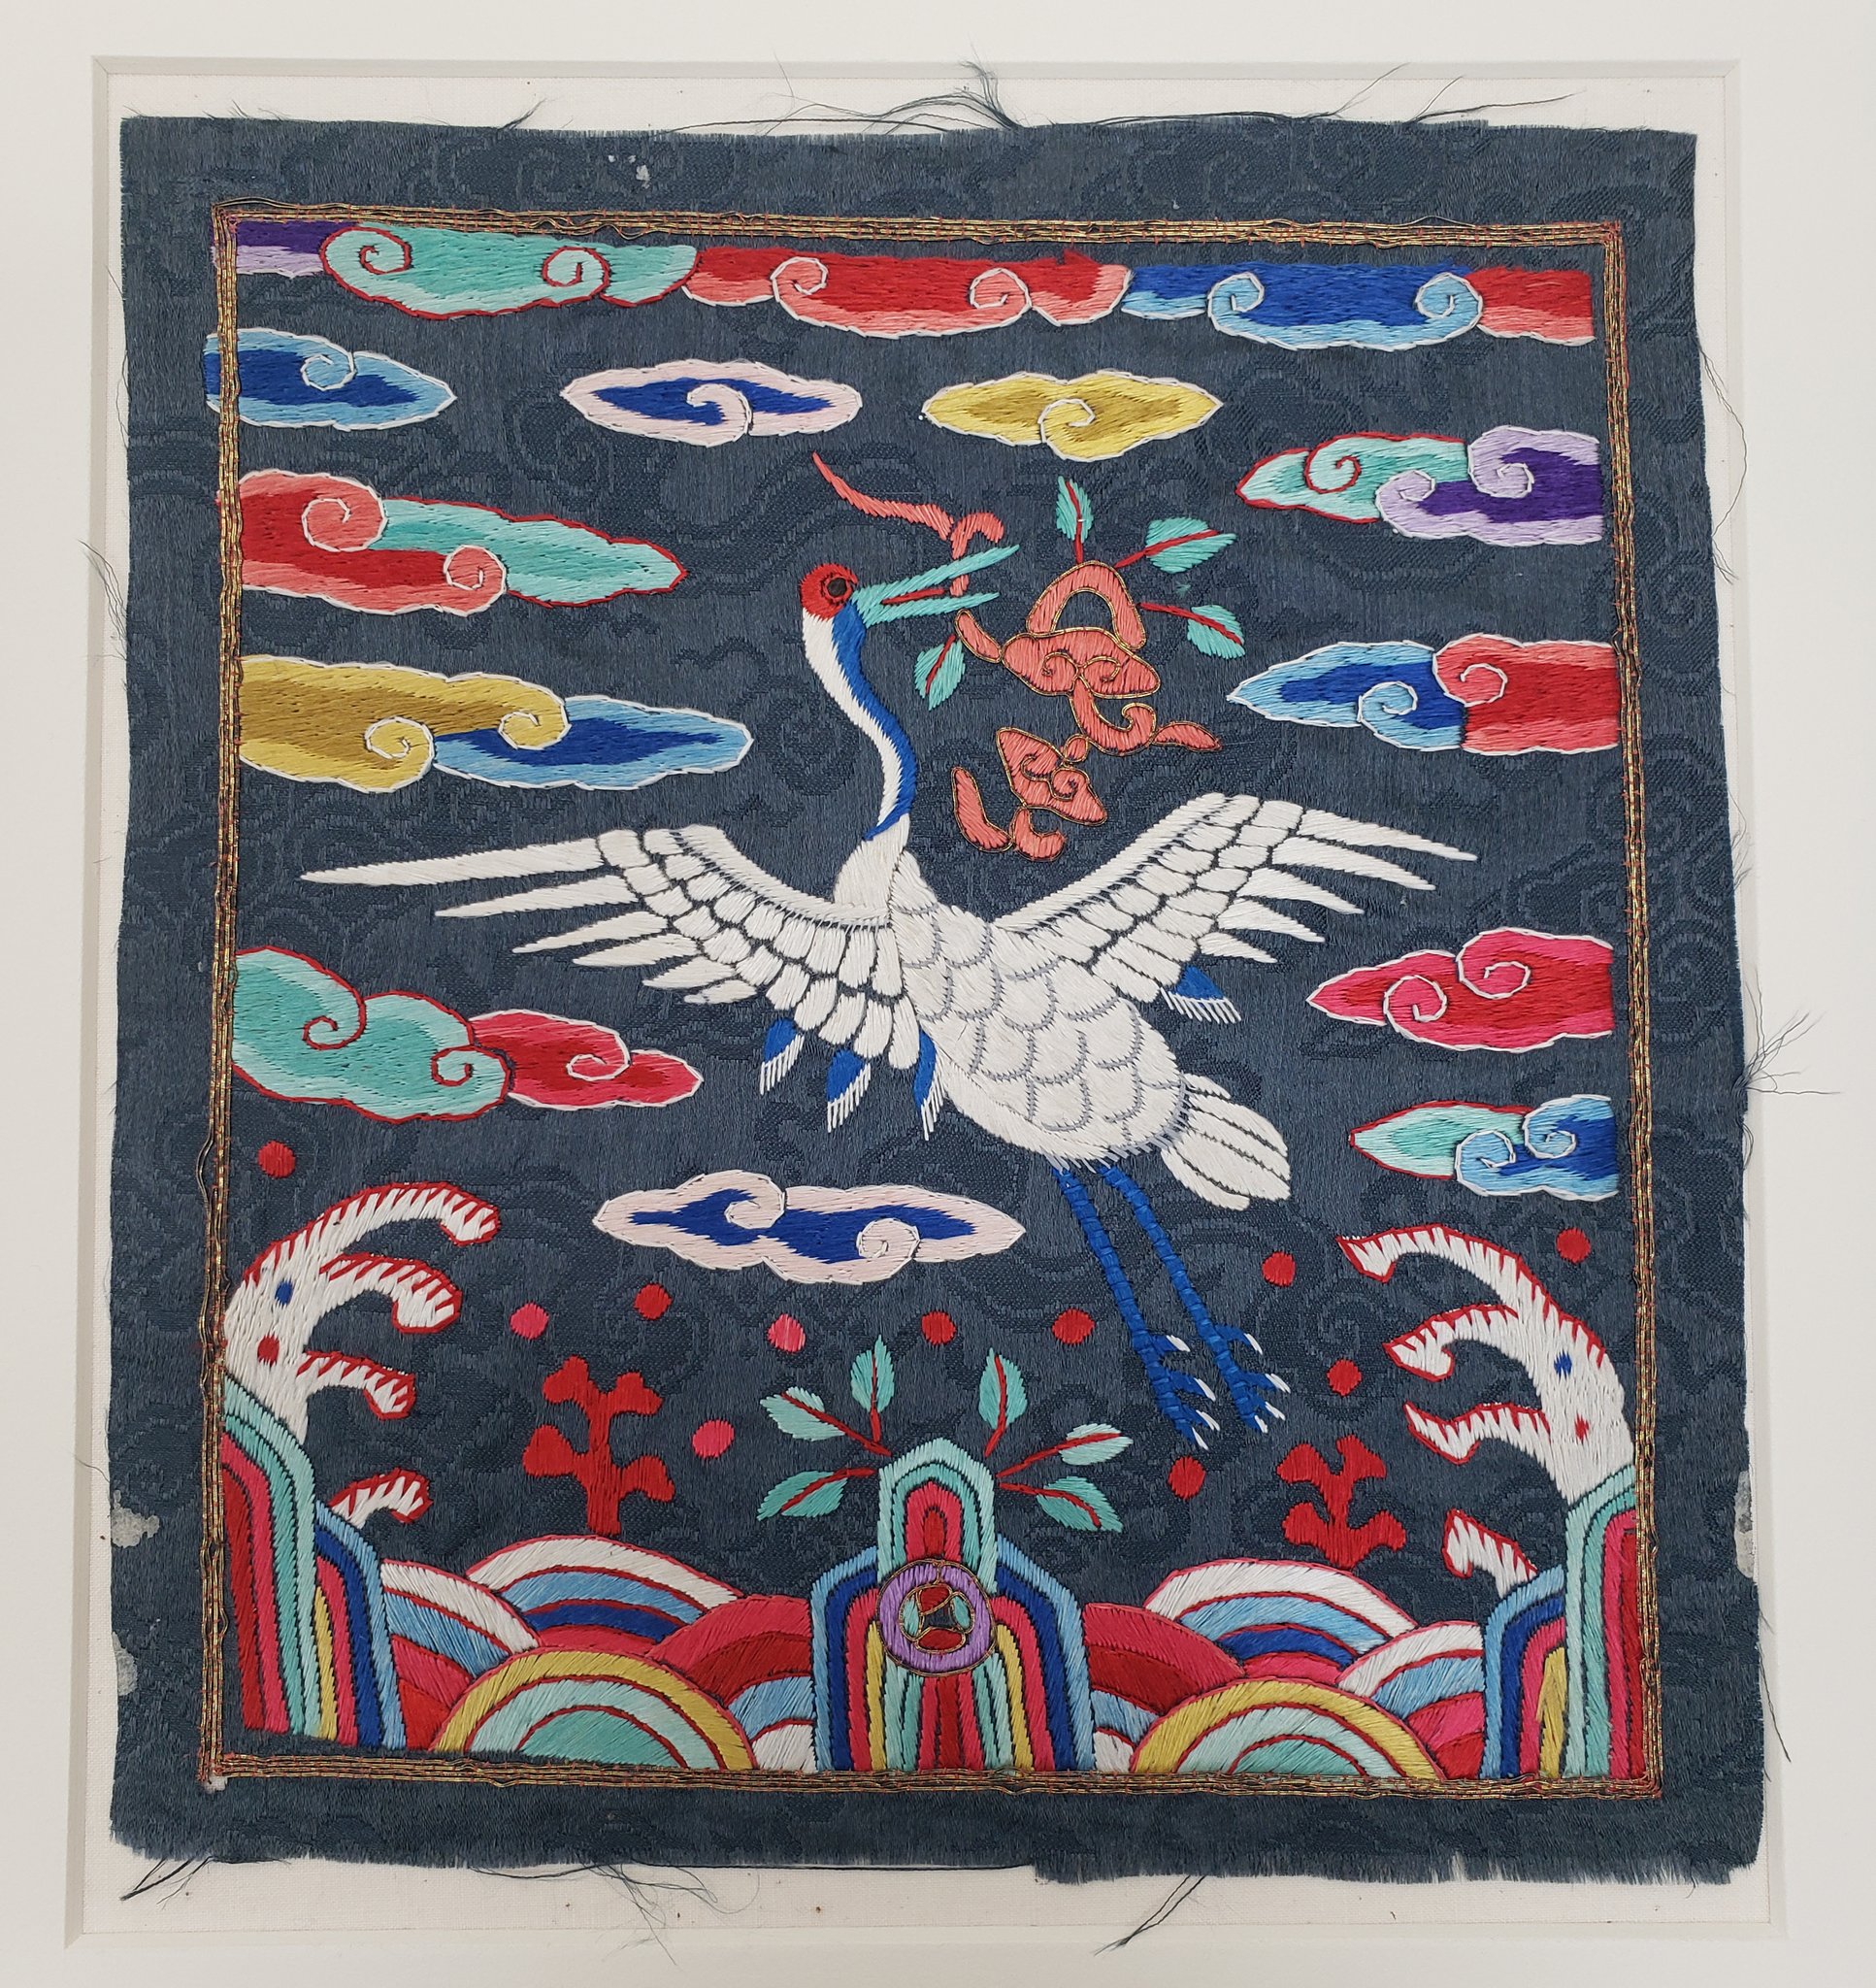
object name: rank badge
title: Civil-Official Hyungbae (Rank Badge)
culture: korean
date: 1867-1900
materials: silk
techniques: damask, embroidery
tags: cranes